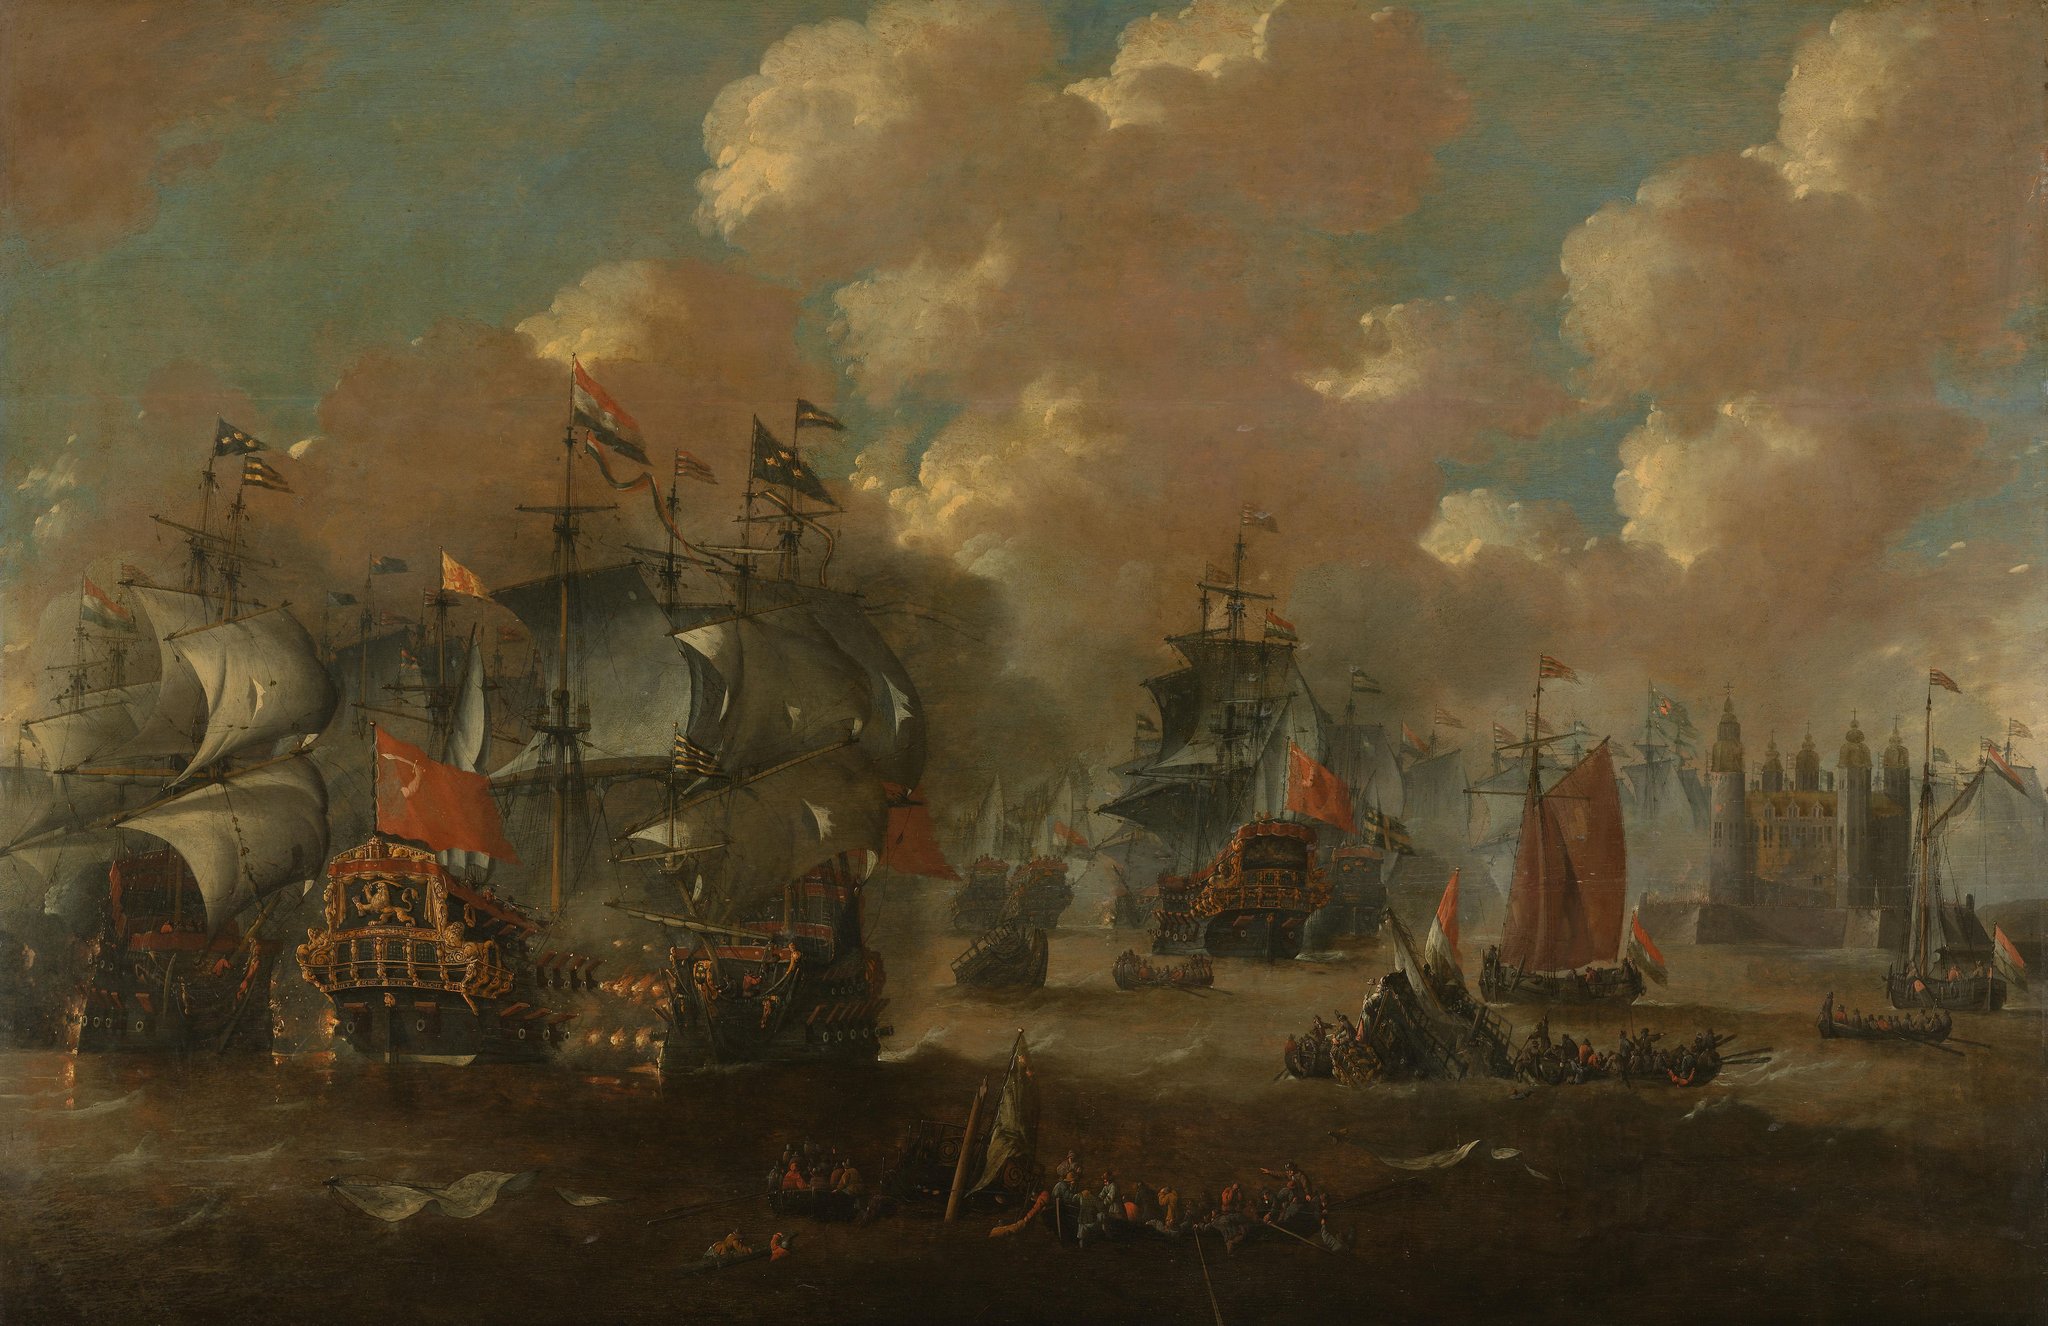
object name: painting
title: The Battle of the Sound with the Eendracht Engaging Two Swedish Warships, 1658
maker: Anonymous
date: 1670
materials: oil, panel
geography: low countries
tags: battle, fighting in general (+ sailing-ships)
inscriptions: signature and date, with initials, bottom centre, on the spar: ‘P.V[…]16[..]’, inscription, centre, on the tafferel of the ship: ‘HET.SCHIP.STAA.VOOREN.’, inscription, lower left, on the tafferel of the ship: ‘HET.SCHIP.DE.EEN.DRACHT.’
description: Zeeslag bij Elseneur in de Sont tussen de Hollandse en de Zweedse vloot, 8 november 1658. Tussen de oorlogsschepen verschillende sloepen en wrakken van gezonken schepen. Op de achtergrond kasteel Kronborg.